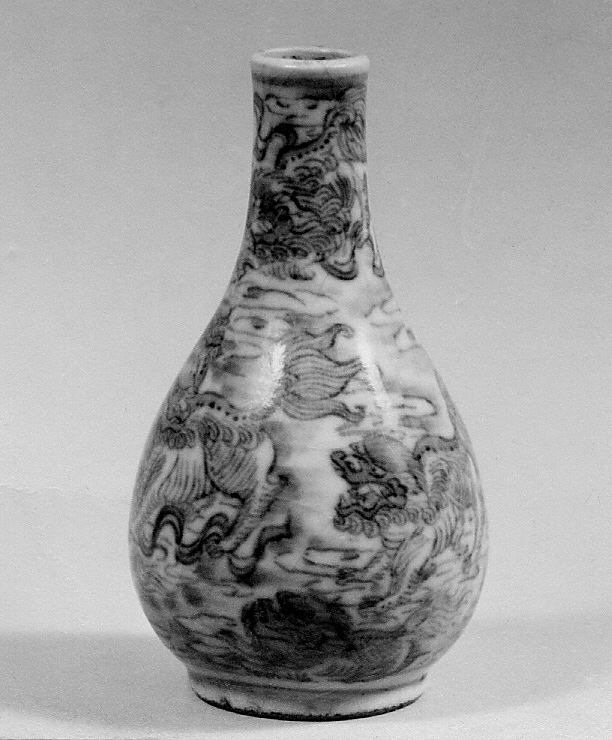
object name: snuff bottle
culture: chinese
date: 1723-1735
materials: porcelain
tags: lions